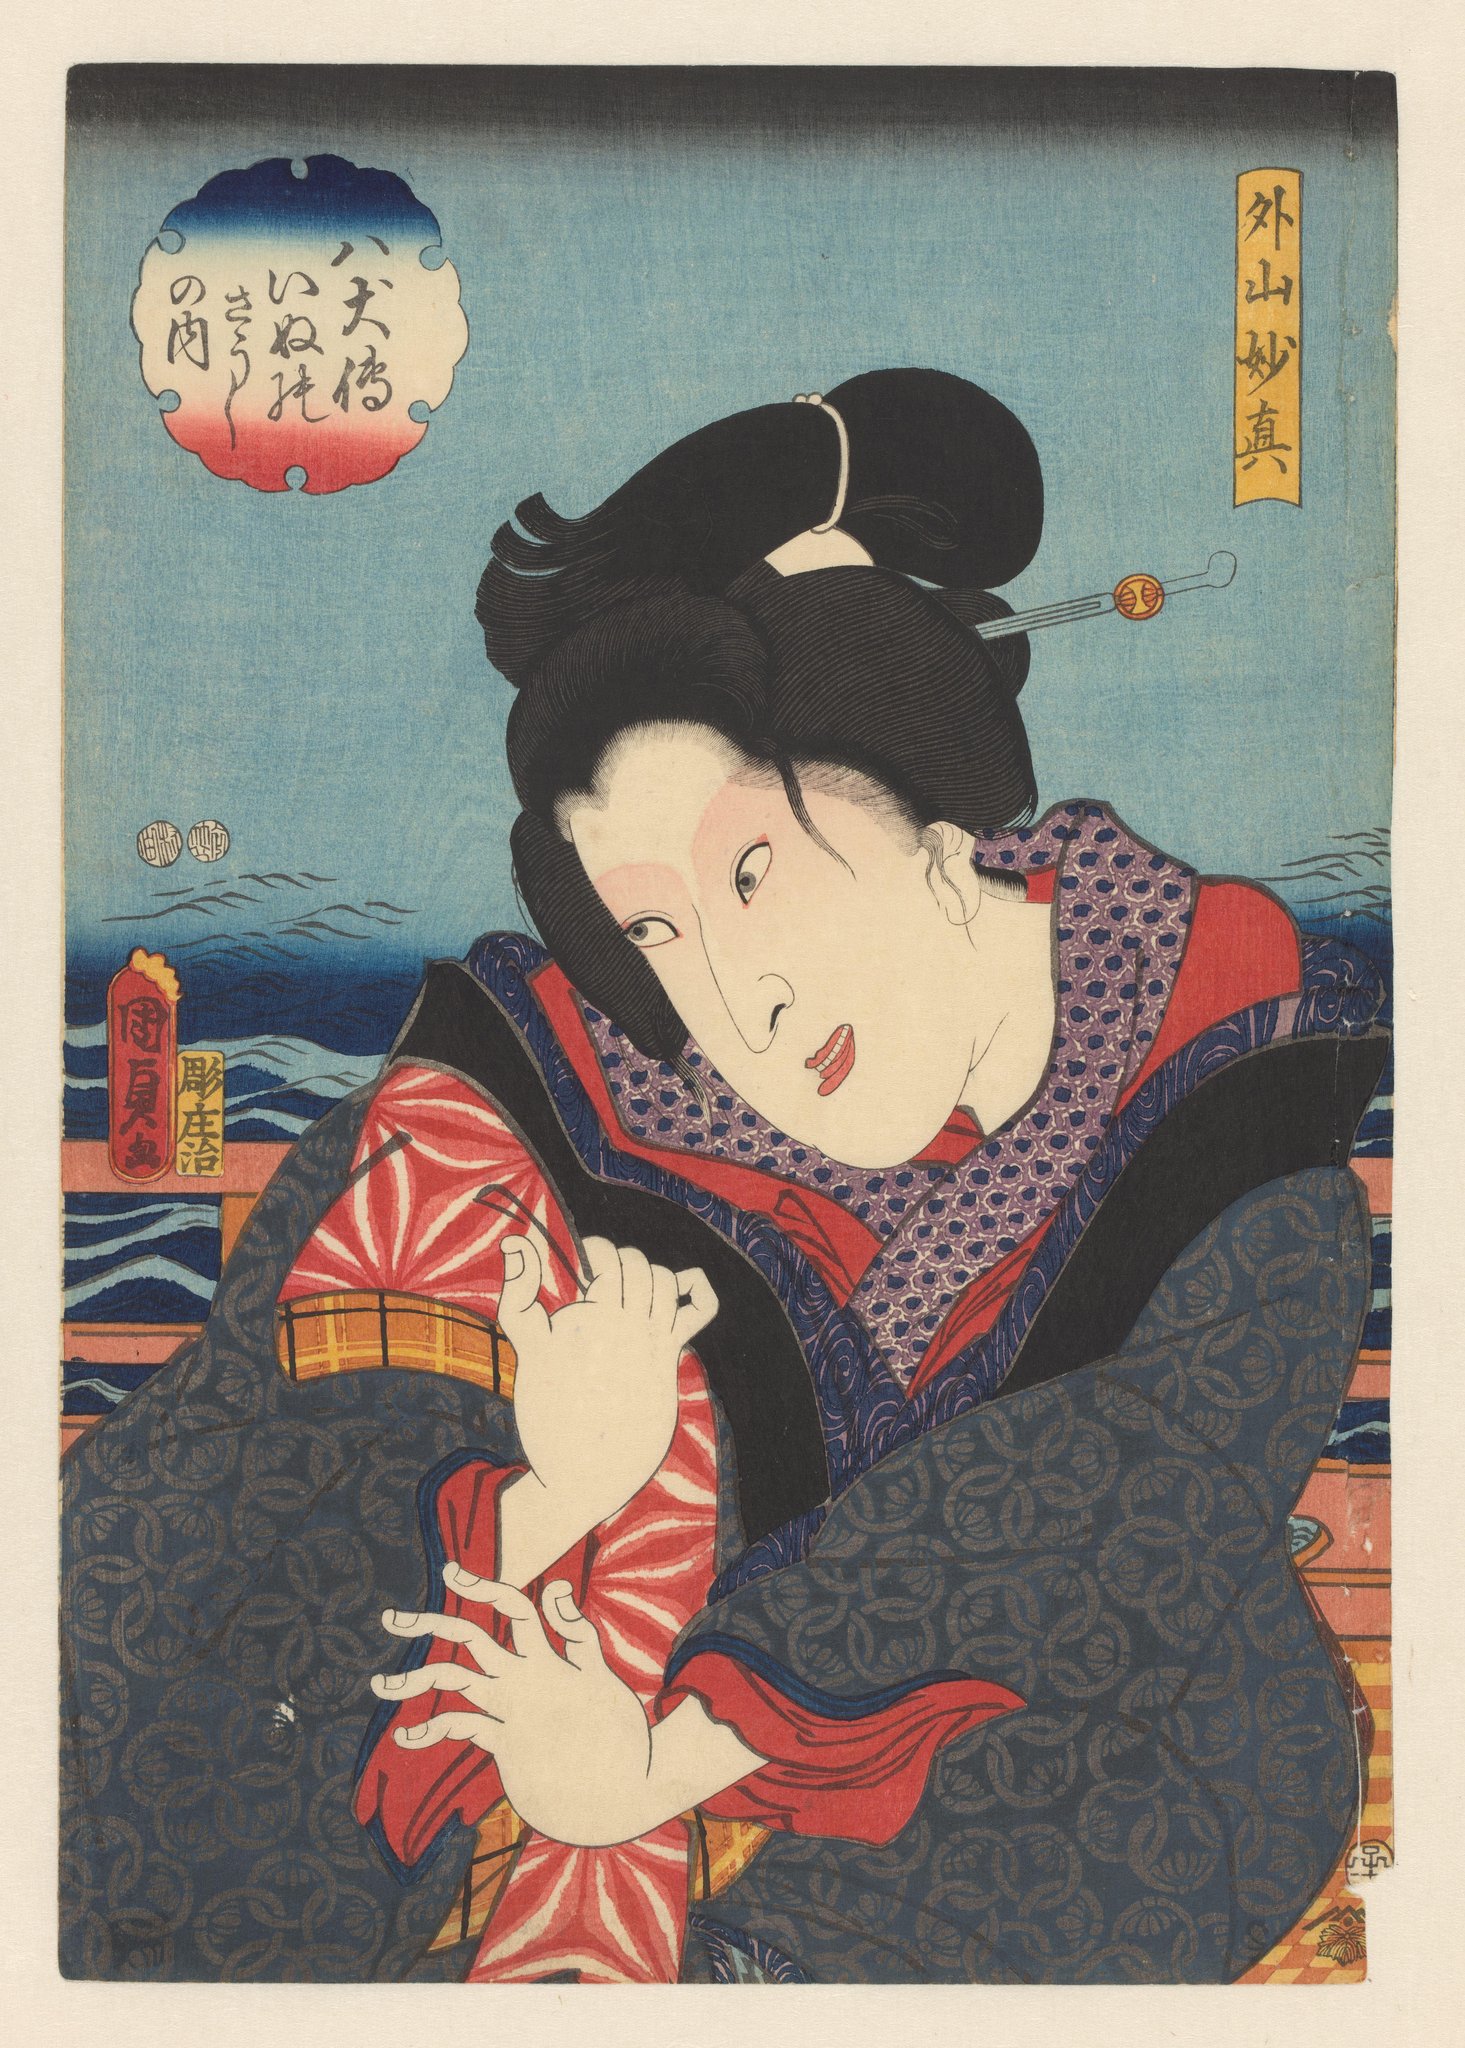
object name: print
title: Biographies of the Eight Dog Heroes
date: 1812-1852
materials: paper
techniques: woodcut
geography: japan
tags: adult woman, water course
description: Sotoyama Myôshin, de moeder van Fusahachirô, op houten veranda, met water op de achtergrond.